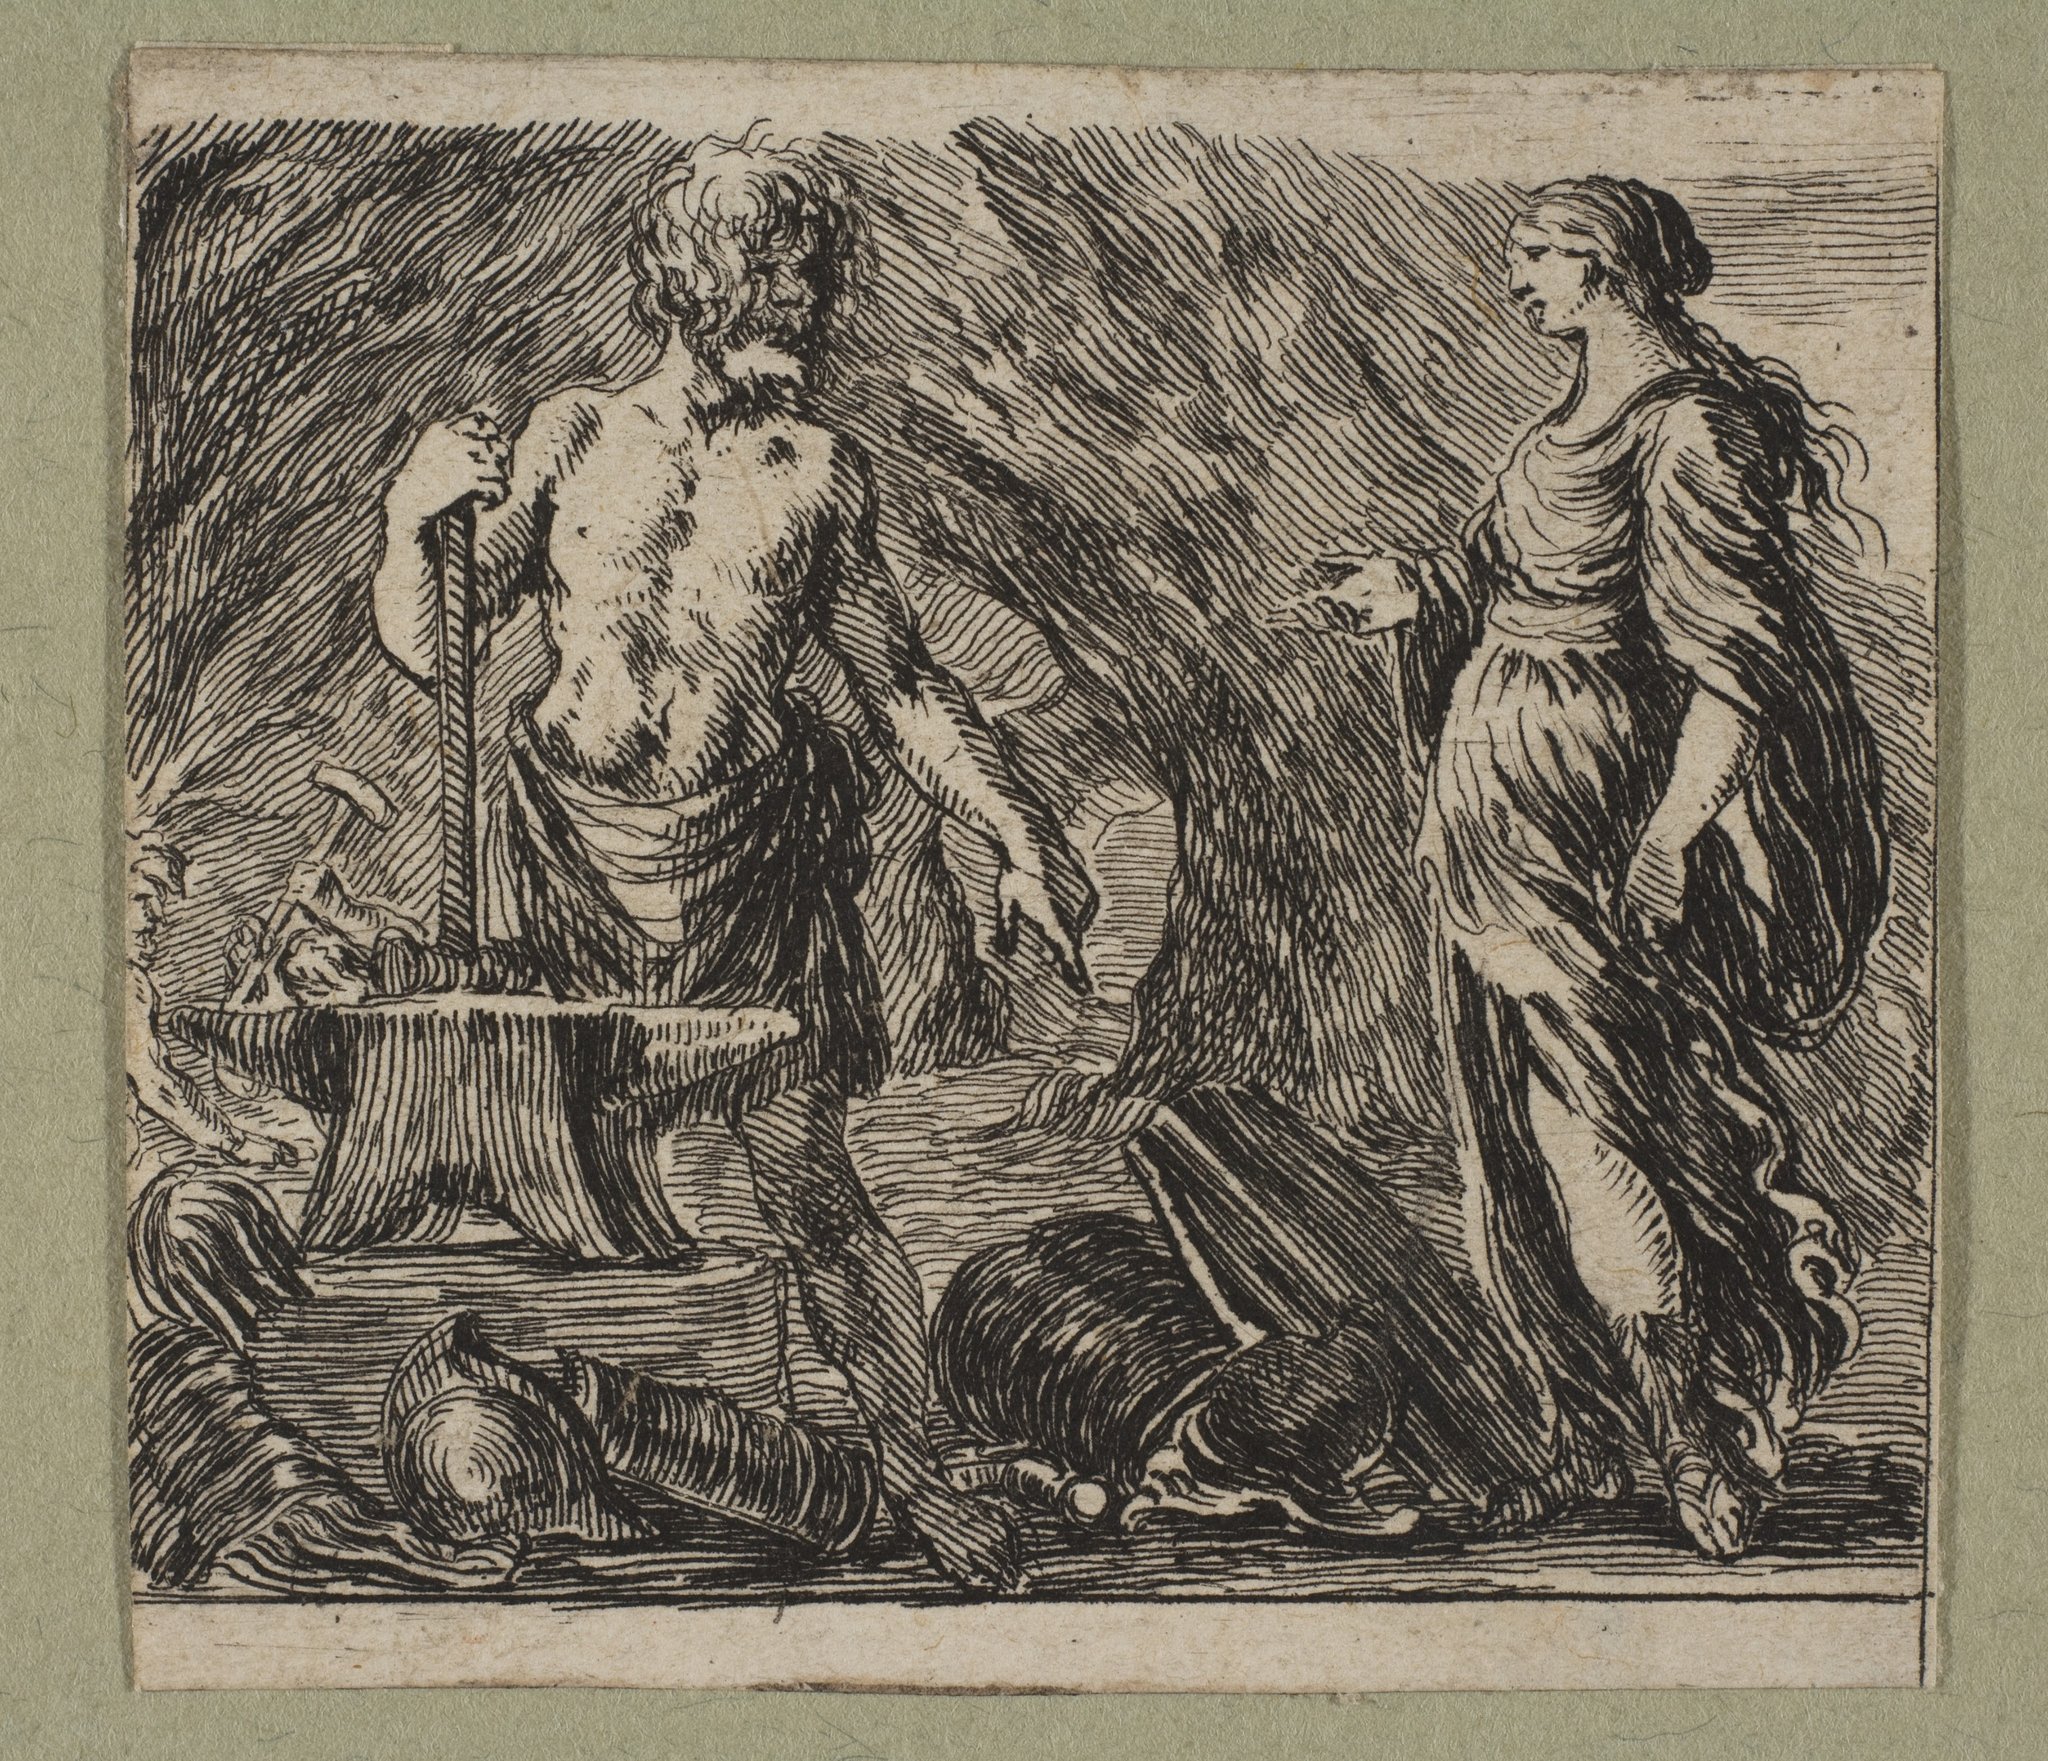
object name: print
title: Vulcan et Thetis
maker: stefano della bella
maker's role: artist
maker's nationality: italian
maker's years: 1610-1664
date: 1644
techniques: etching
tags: vulcan,goddess